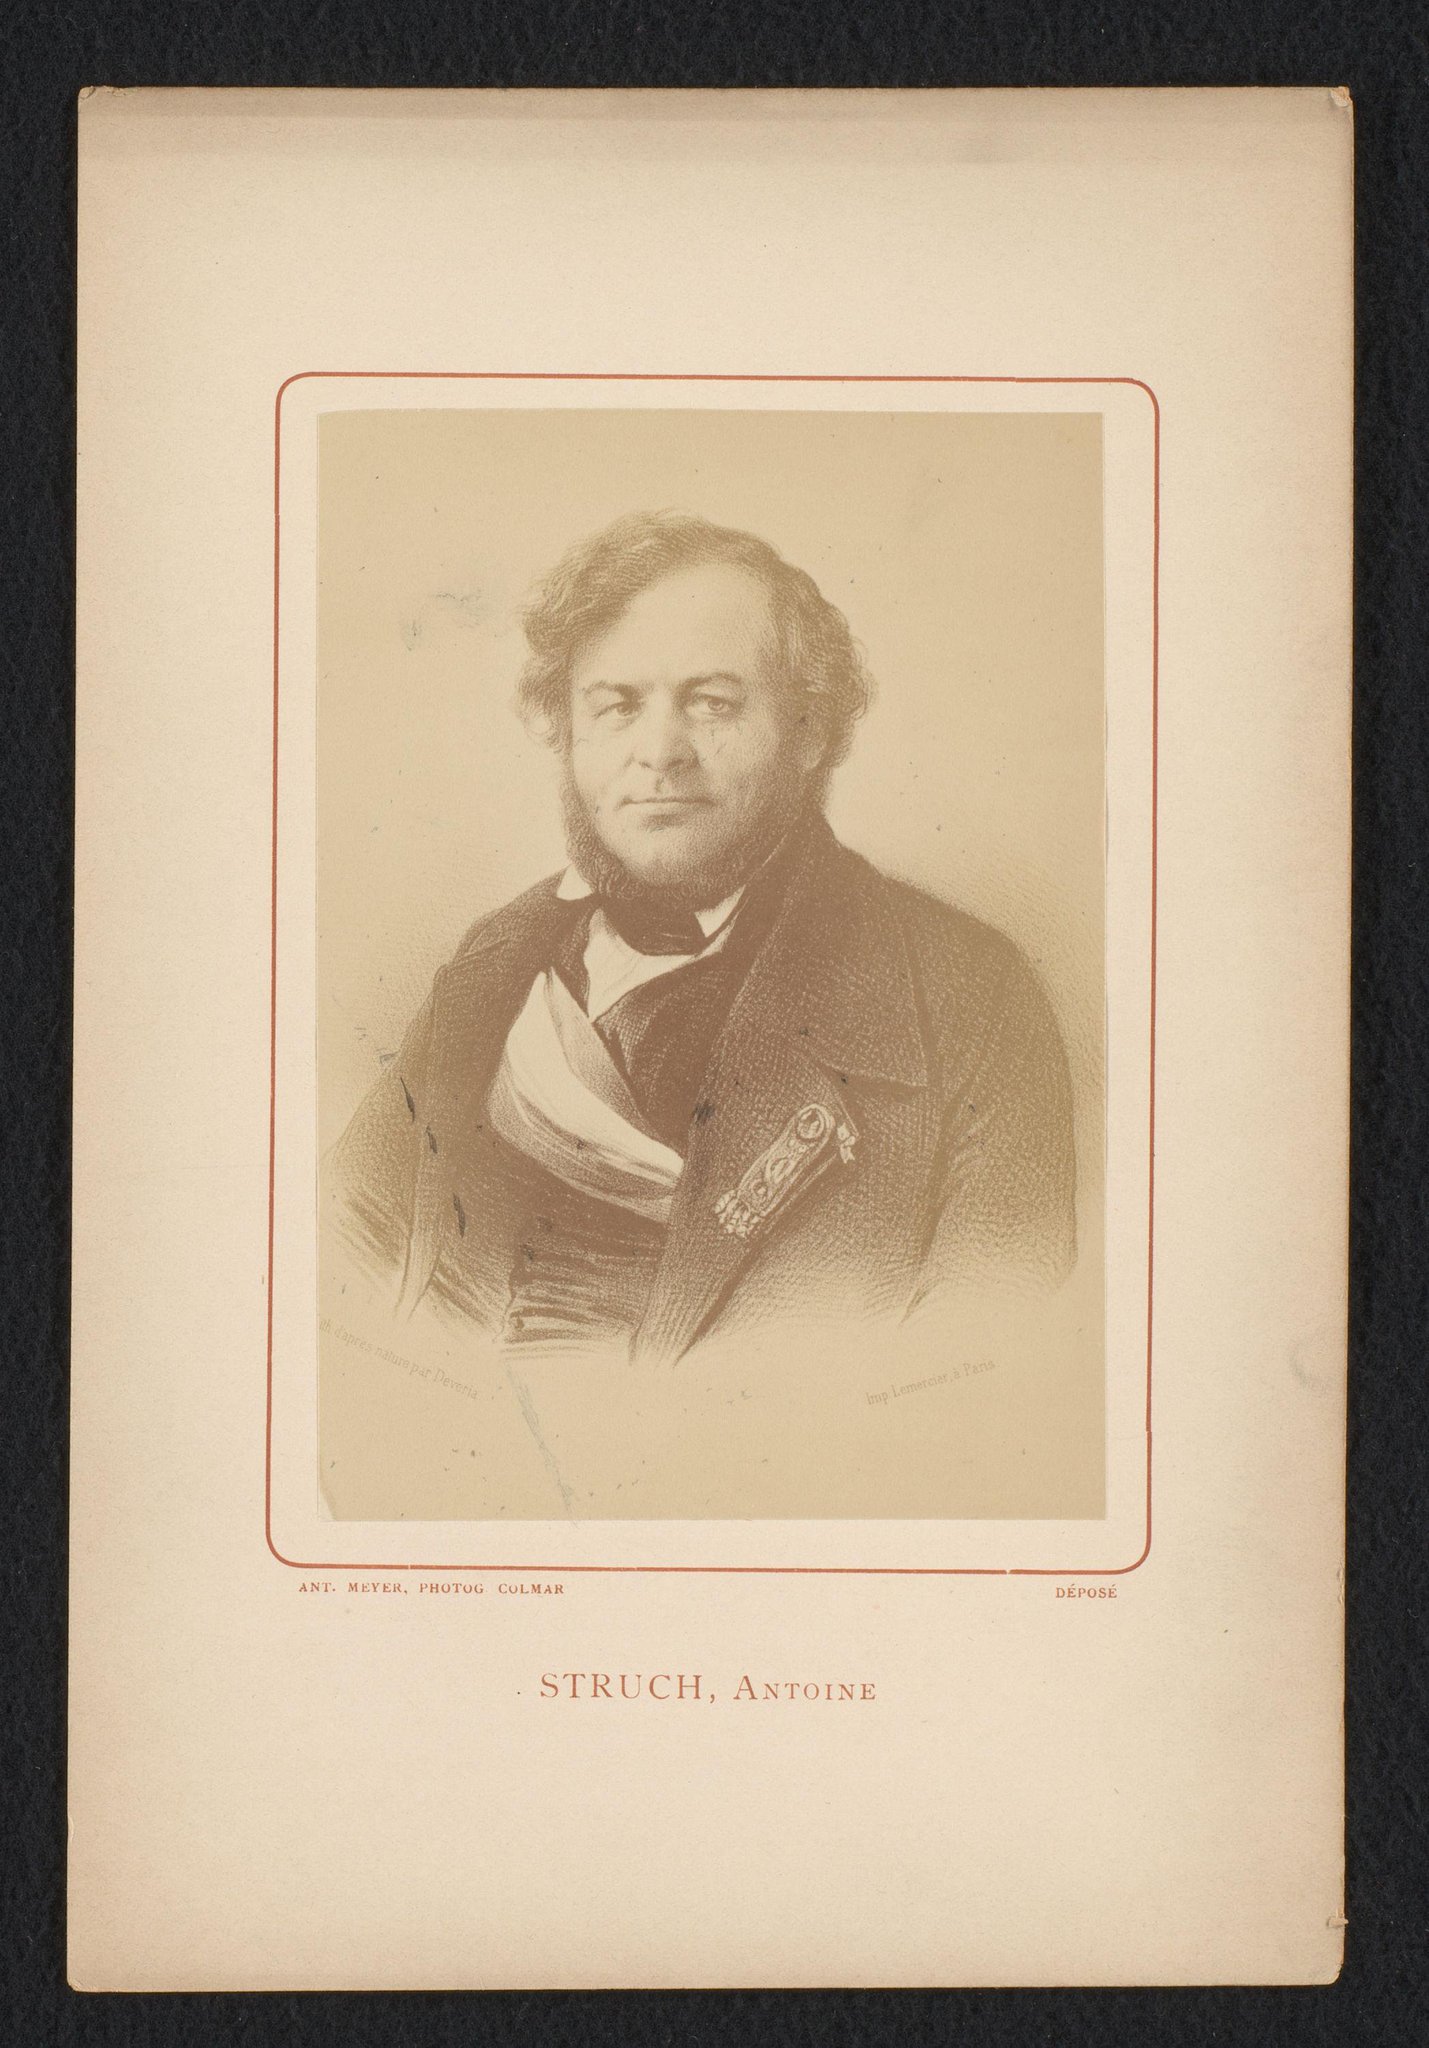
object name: reproduction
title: Fotoreproductie van een prent van een portret van Antoine Struch door Achille Devéria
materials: photographic support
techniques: albumen print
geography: colmar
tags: historical persons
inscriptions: inscription: ‘Déposé’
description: Deze foto maakt deel uit van een omslag met 29 foto's op 29 bladen en 23 teksbladen.